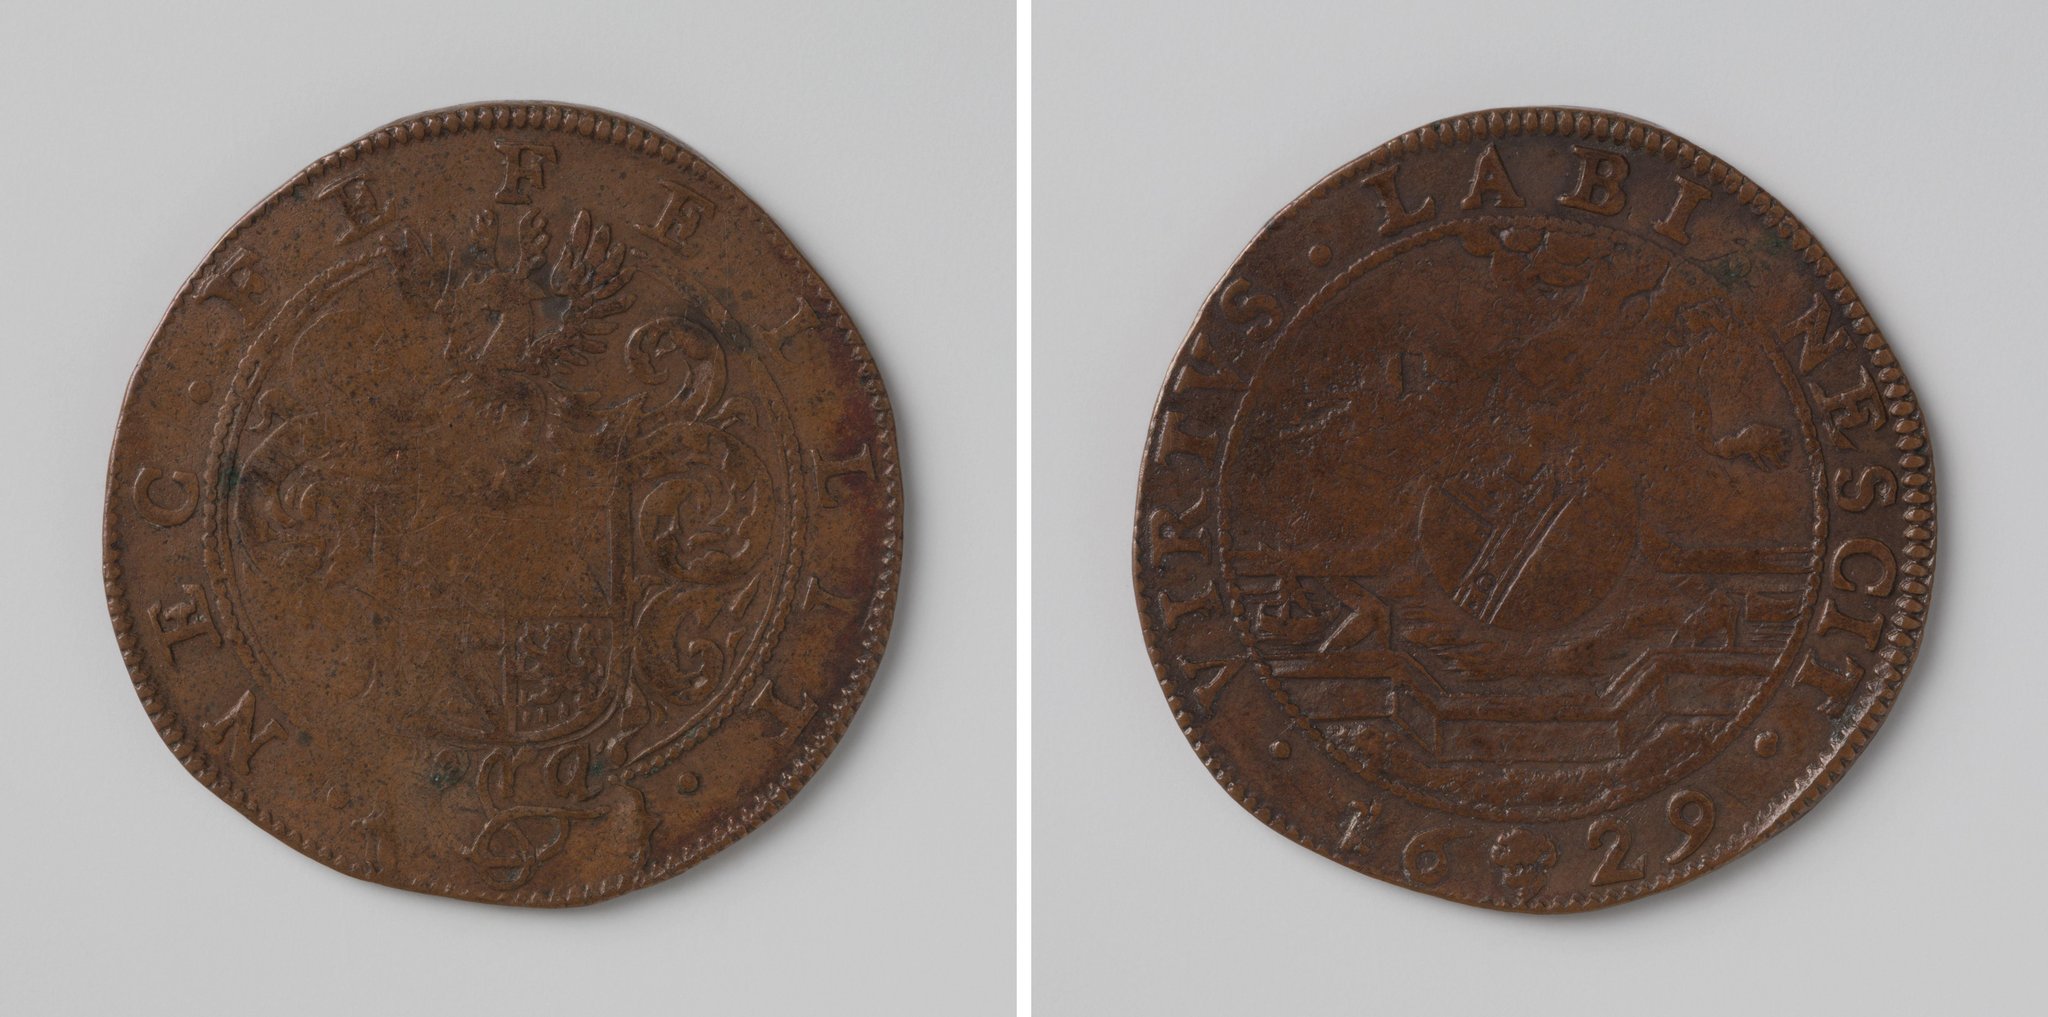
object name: jeton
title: Antoine de Locquenghien, zesentwintigste intendant van de vaart van Brussel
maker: Anonymous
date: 1629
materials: copper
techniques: striking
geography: brussels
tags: antoine de locquenghien, willebroekse vaart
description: Koperen penning. Voorzijde: gehelmd wapenschild binnen omschrift. Keerzijde: schip voor sluis; daarboven houdt een hand een rijksappel binnen omschrift